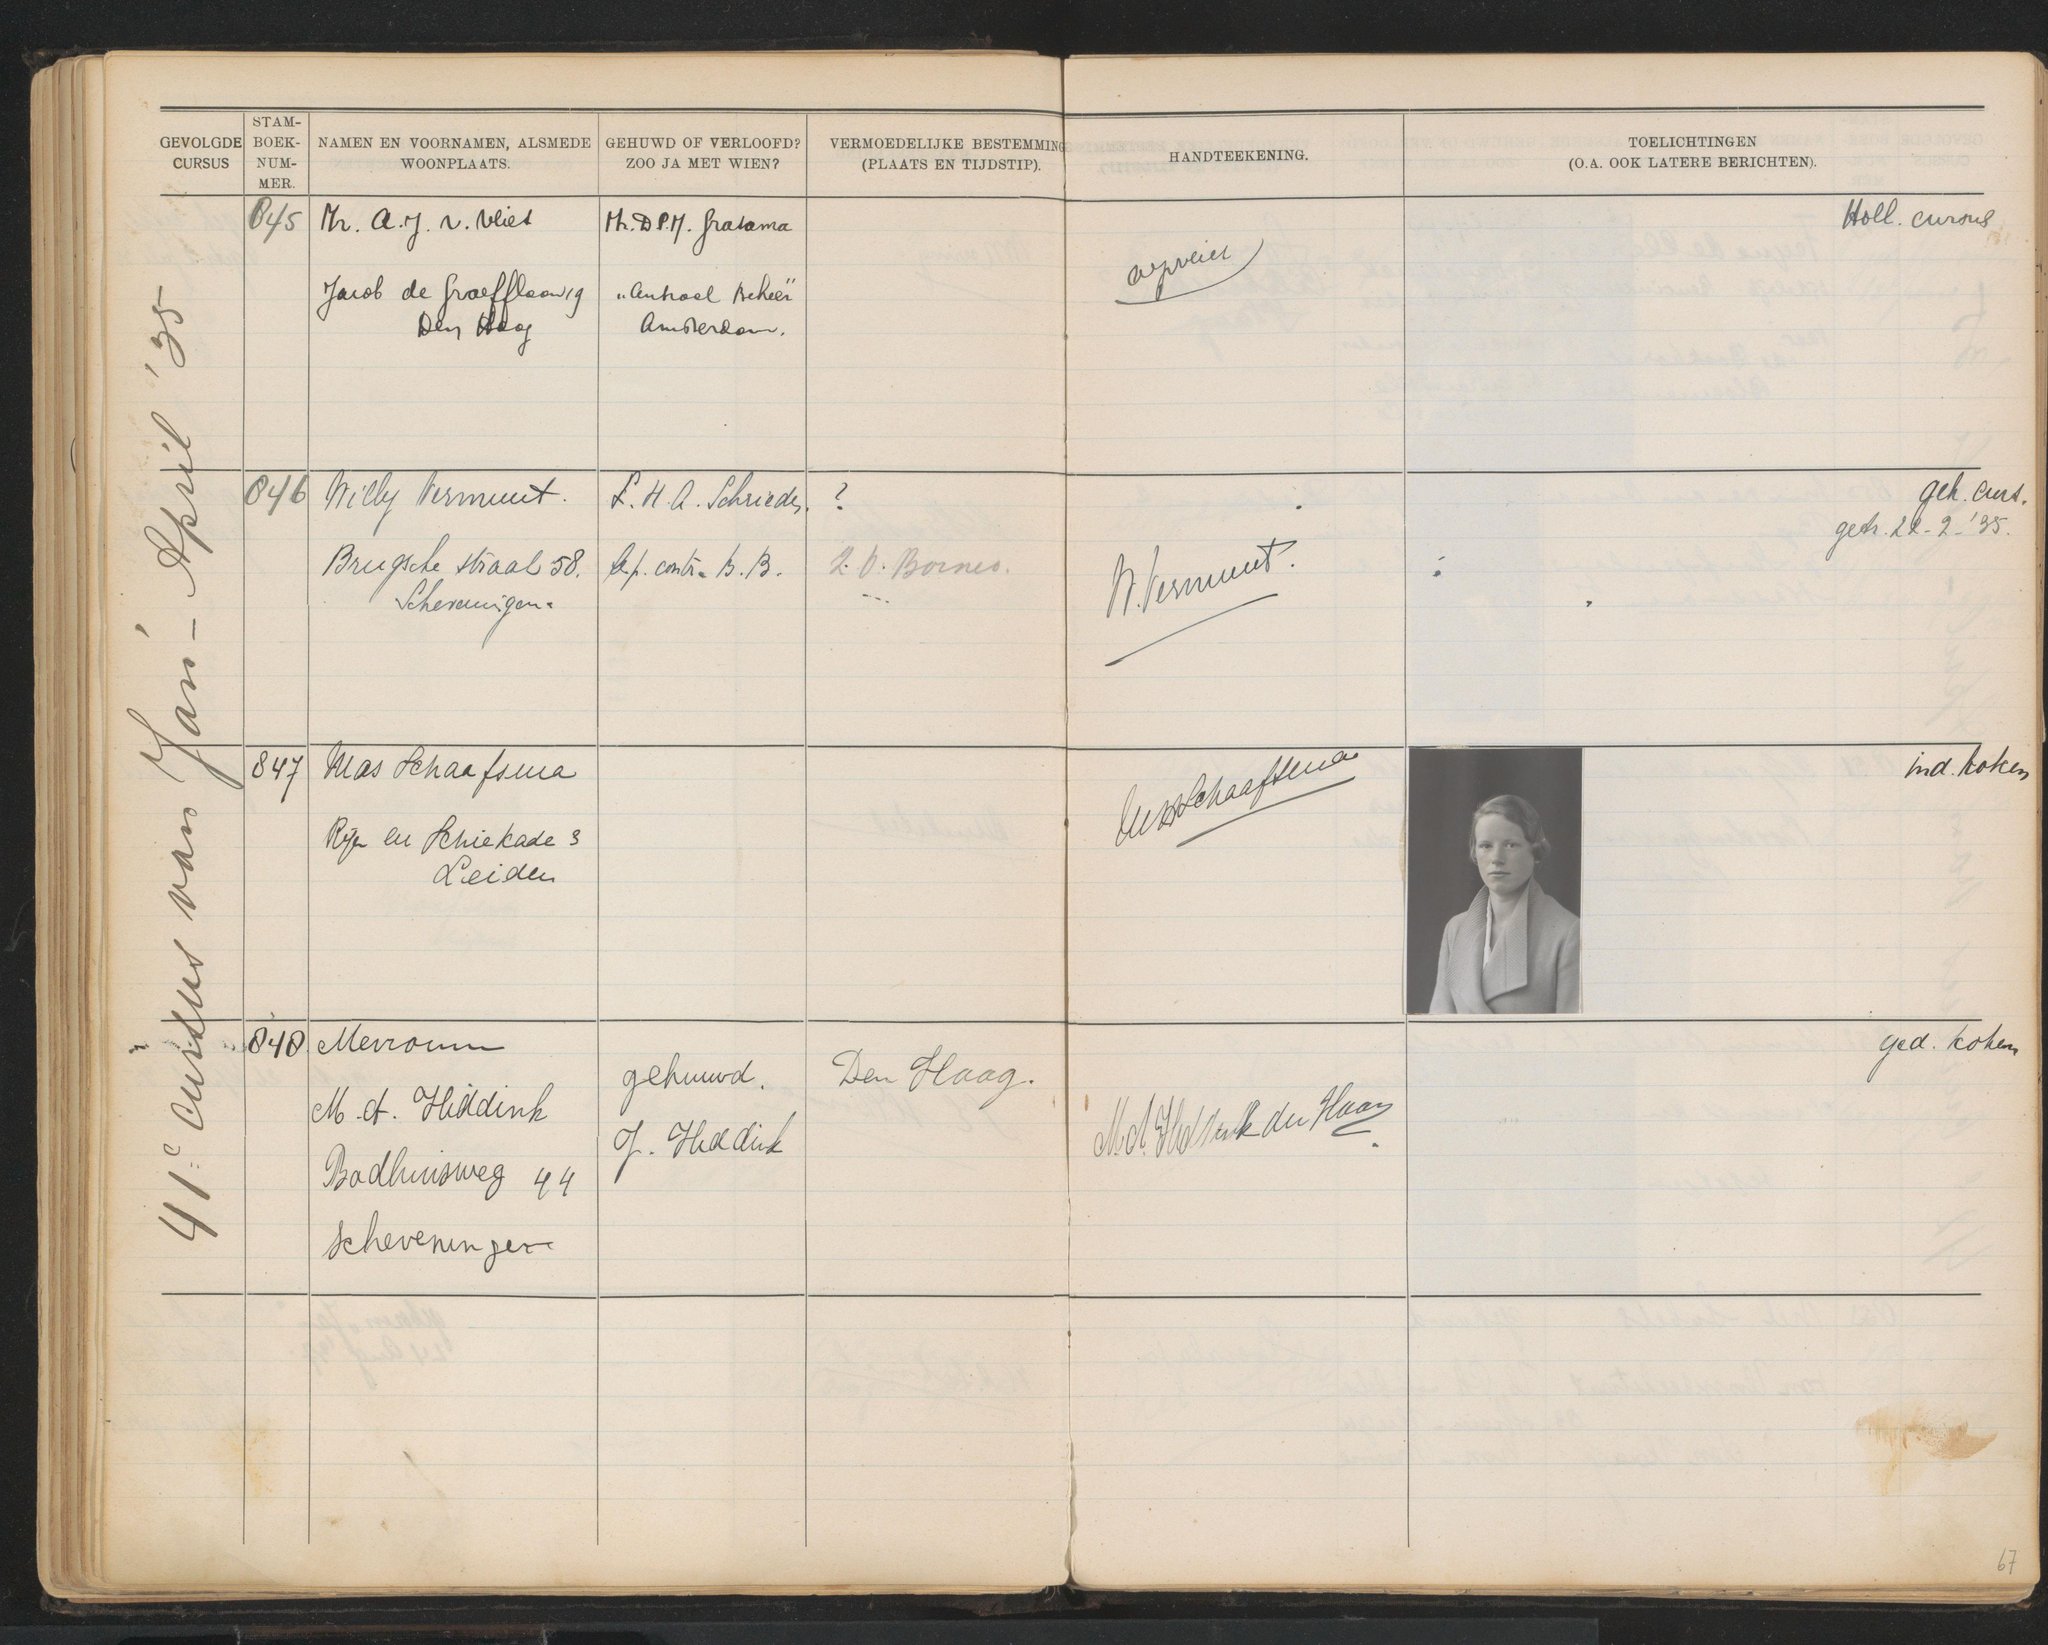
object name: album leaf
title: Blad 67 uit Stamboek van de leerlingen der Koloniale School voor Meisjes en Vrouwen te 's-Gravenhage deel II (1930-1949)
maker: Anonymous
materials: paper, photographic support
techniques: photography, printing, writing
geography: the hague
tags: further education (+ pupil), further education, the hague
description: Twee pagina's met gegevens van de deelnemers aan de 41e driemaandelijkse cursus van januari tot april 1935, stamboeknummers 845 tot en met 848. Onderdeel van Stamboek van de leerlingen der Koloniale School voor Meisjes en Vrouwen te 's-Gravenhage deel II (1930-1949).